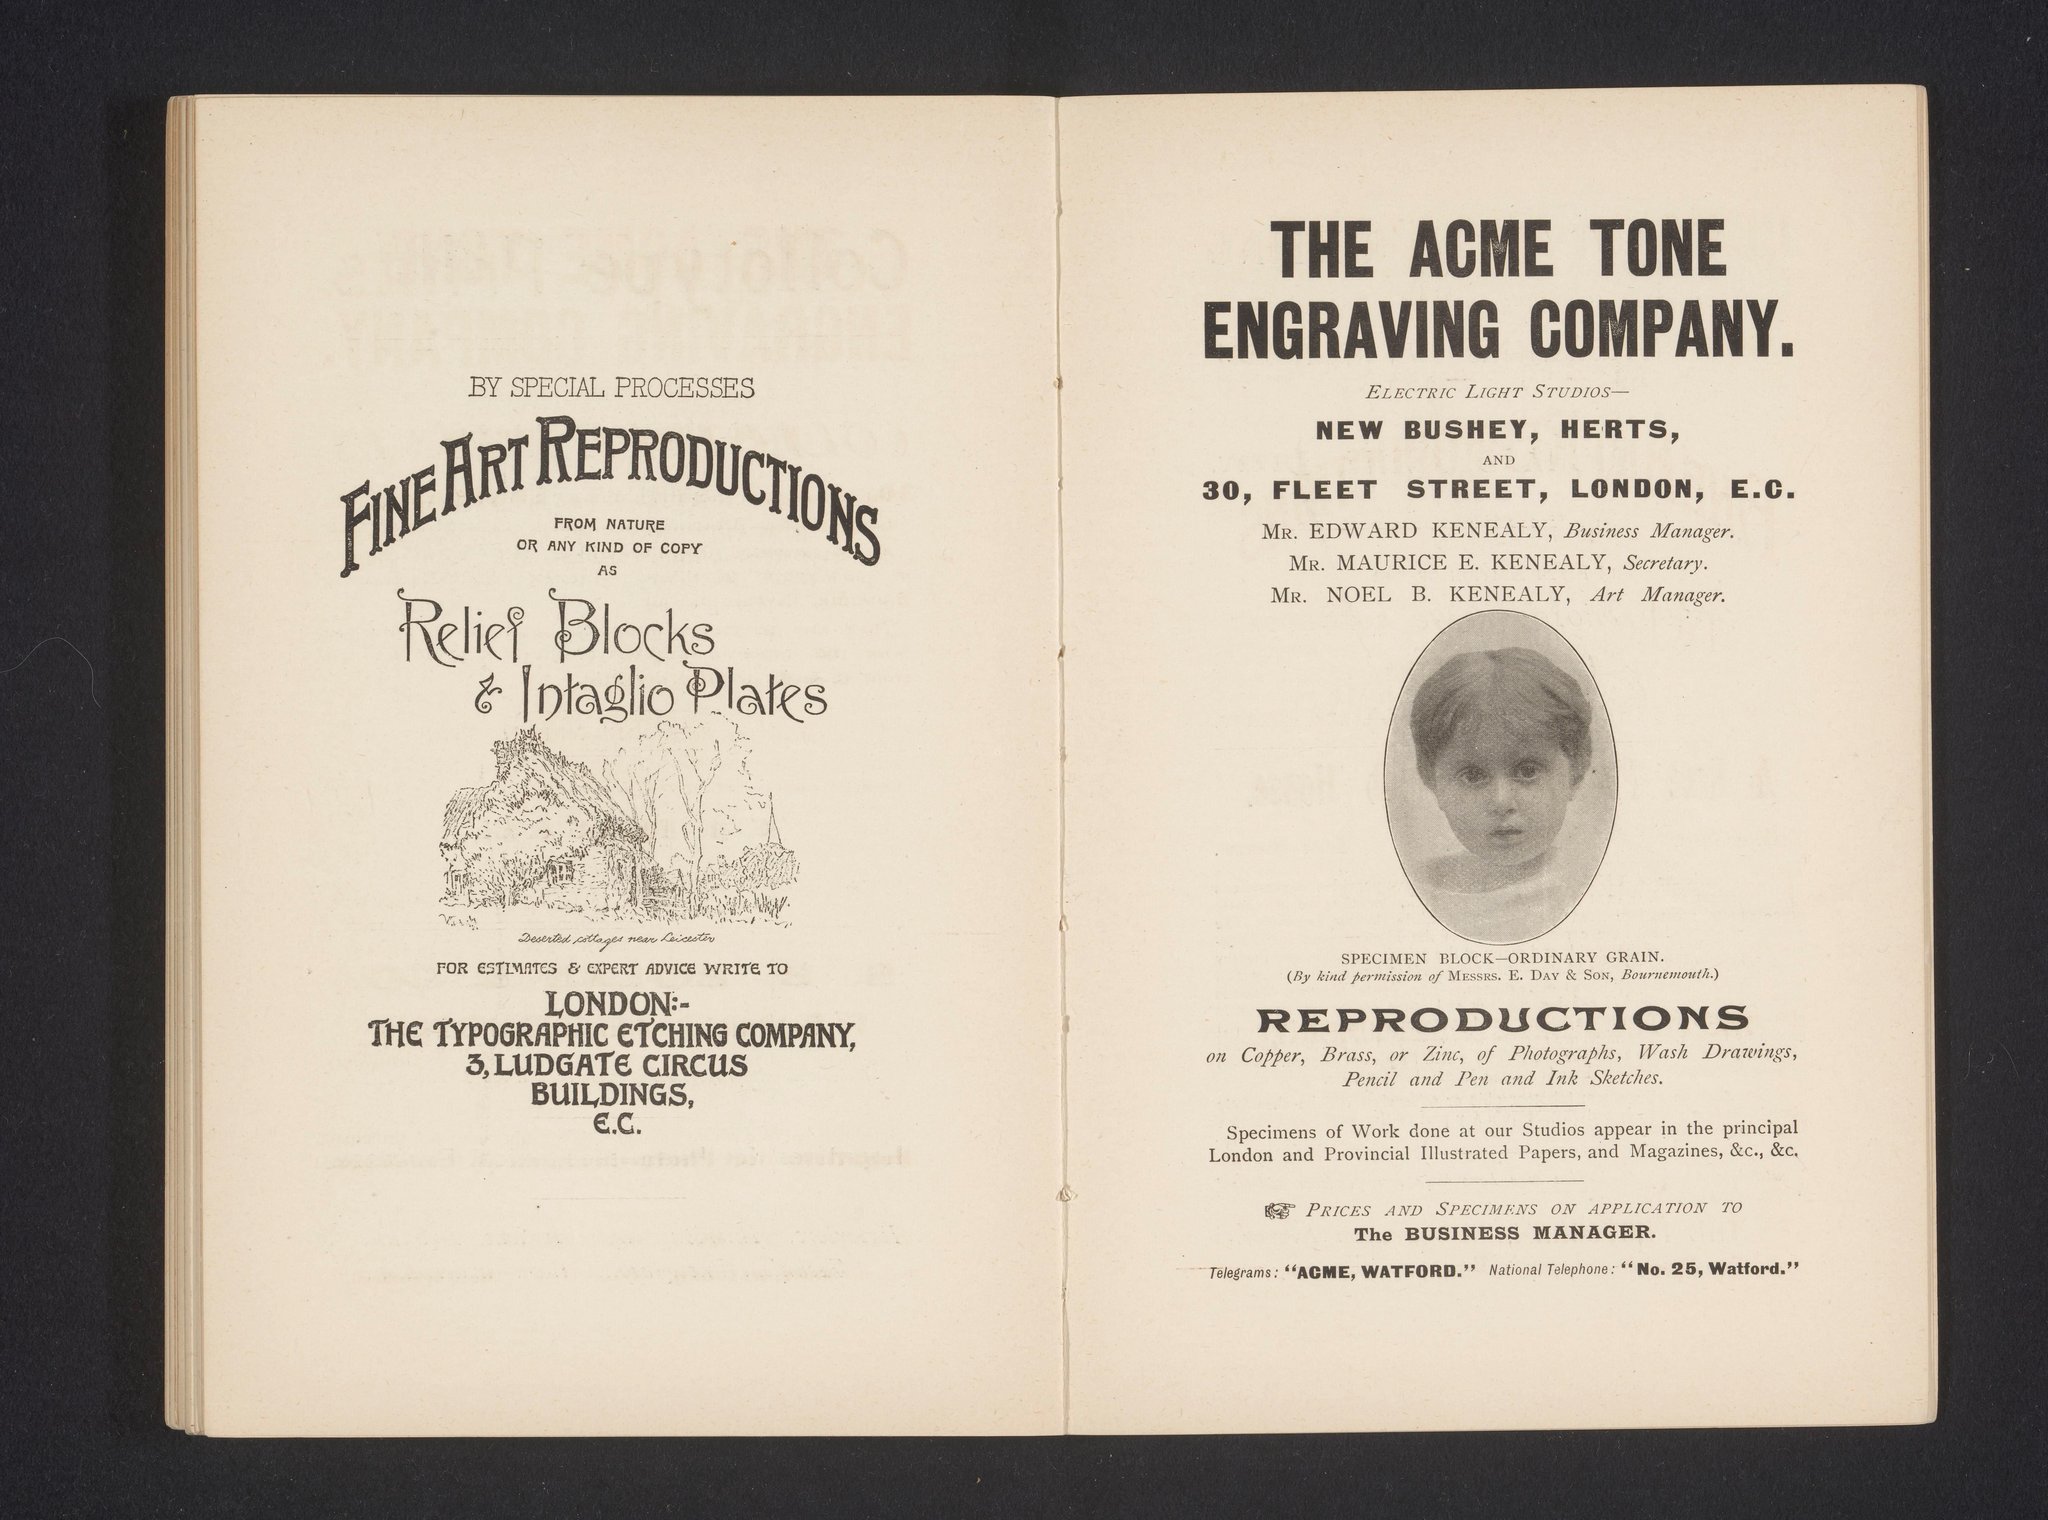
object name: advertisement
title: Portret van een onbekend kind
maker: Anonymous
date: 1884-1894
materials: paper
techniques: autotype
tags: child (at home)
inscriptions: inscription: ‘The Acme tone engraving company. Electric Light Studios-(...)’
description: Pagina is een advertentie van de firma The Acme Tone Engraving Company.